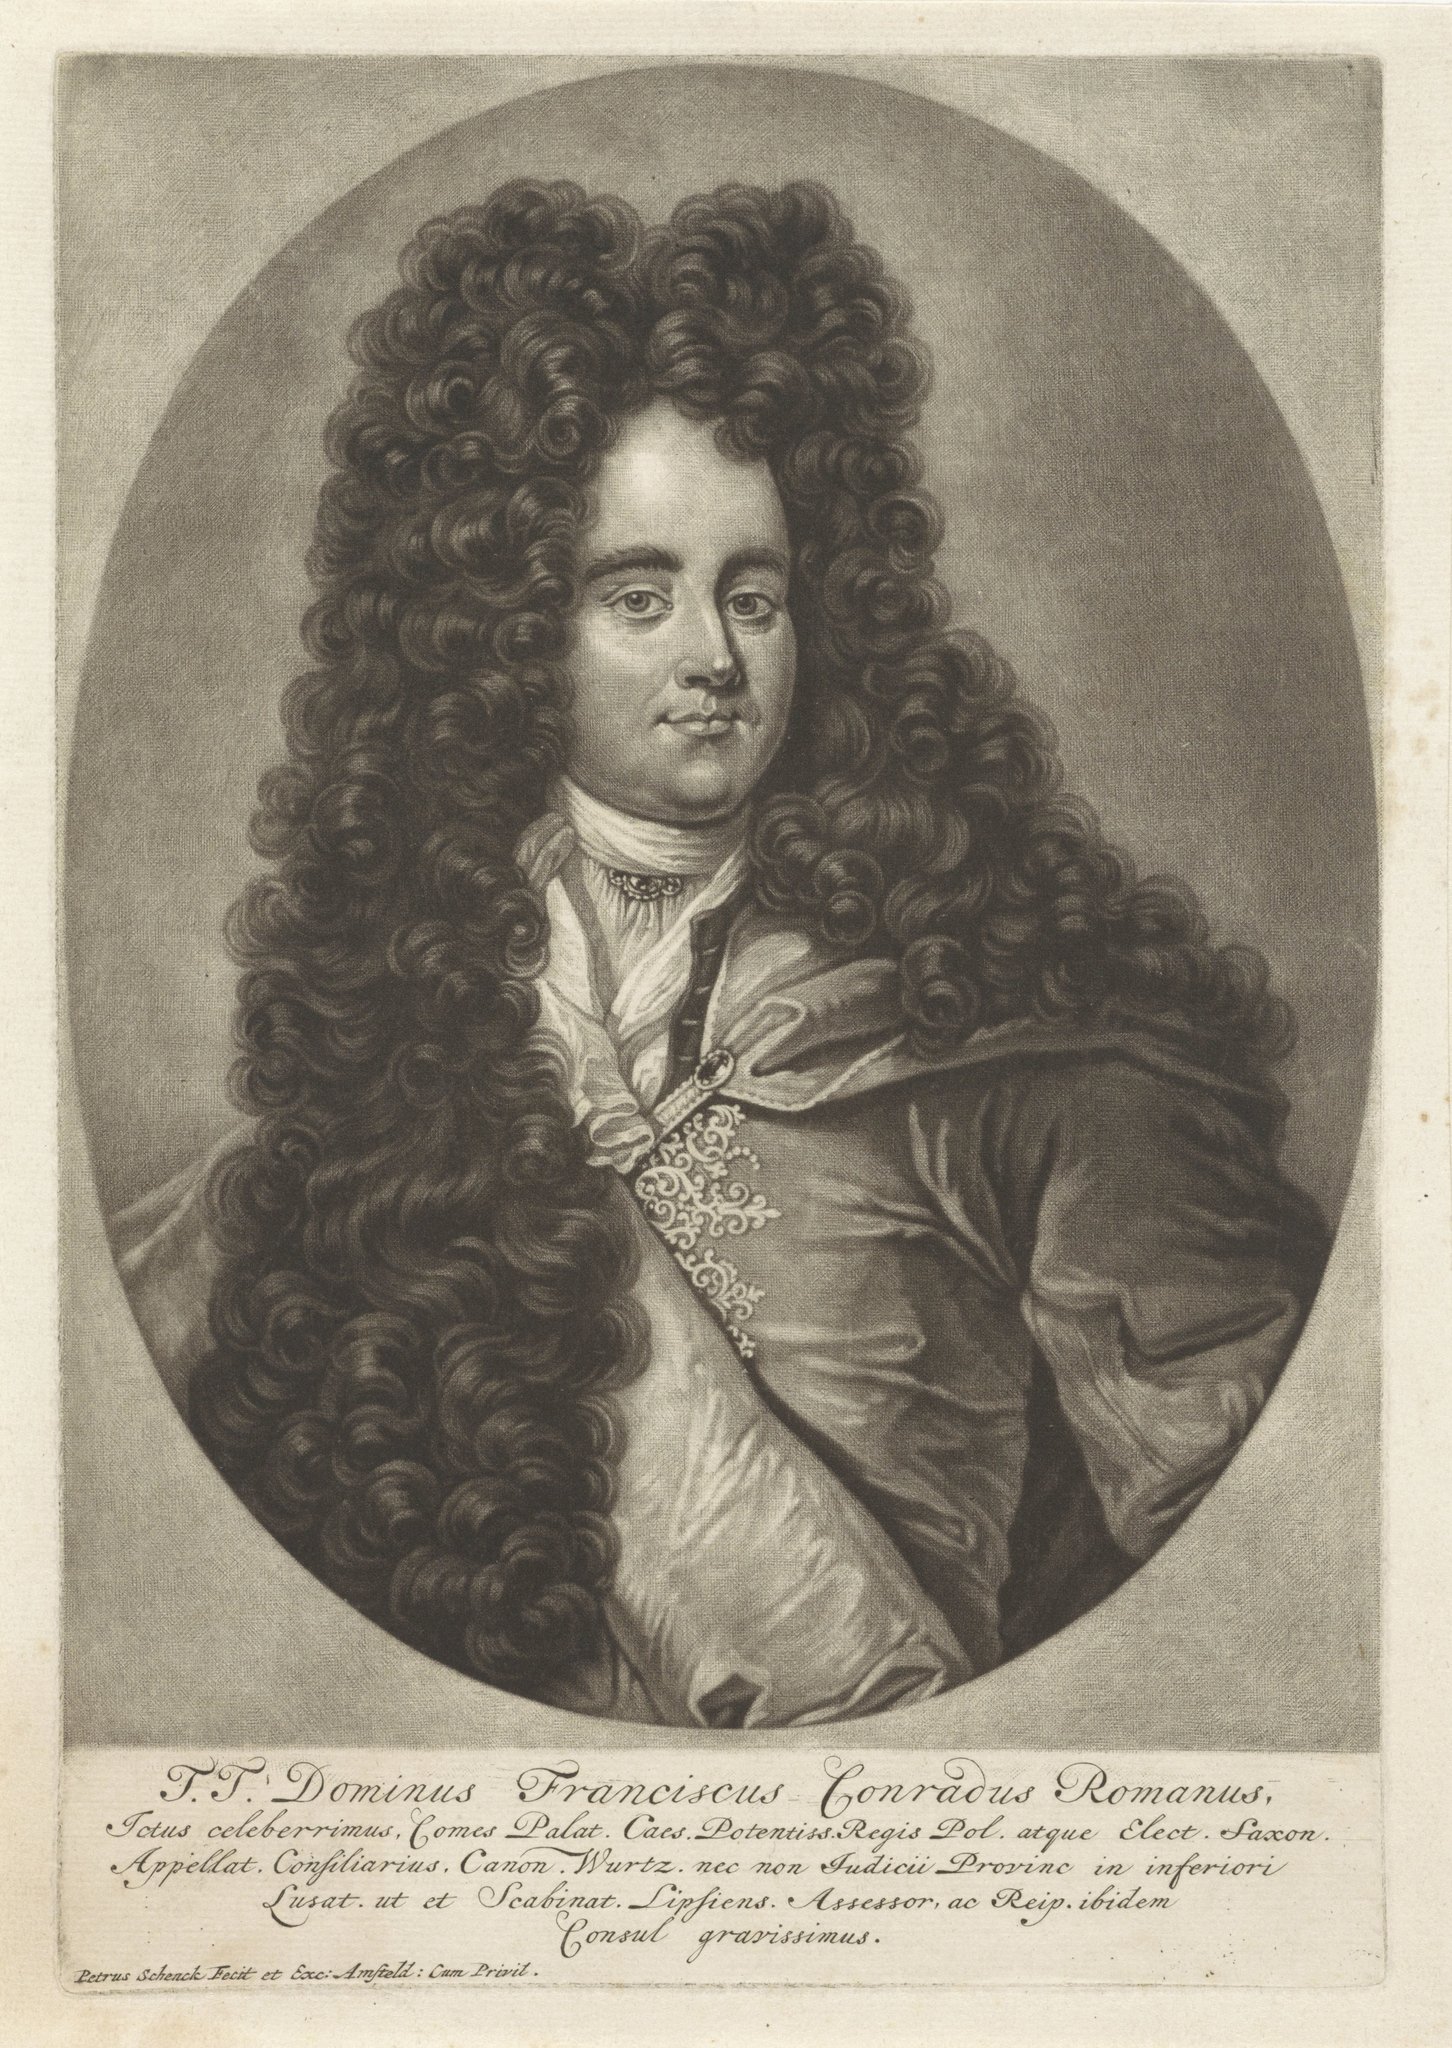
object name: print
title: Portret van Franz Konrad Romanus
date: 1700-1713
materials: paper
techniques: engraving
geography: amsterdam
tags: mayor, wig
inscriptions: collector's mark: Lugt 2228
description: Franz Konrad Romanus, jurist en burgemeester te Leipzig. Hij draagt een lange krulpruik.